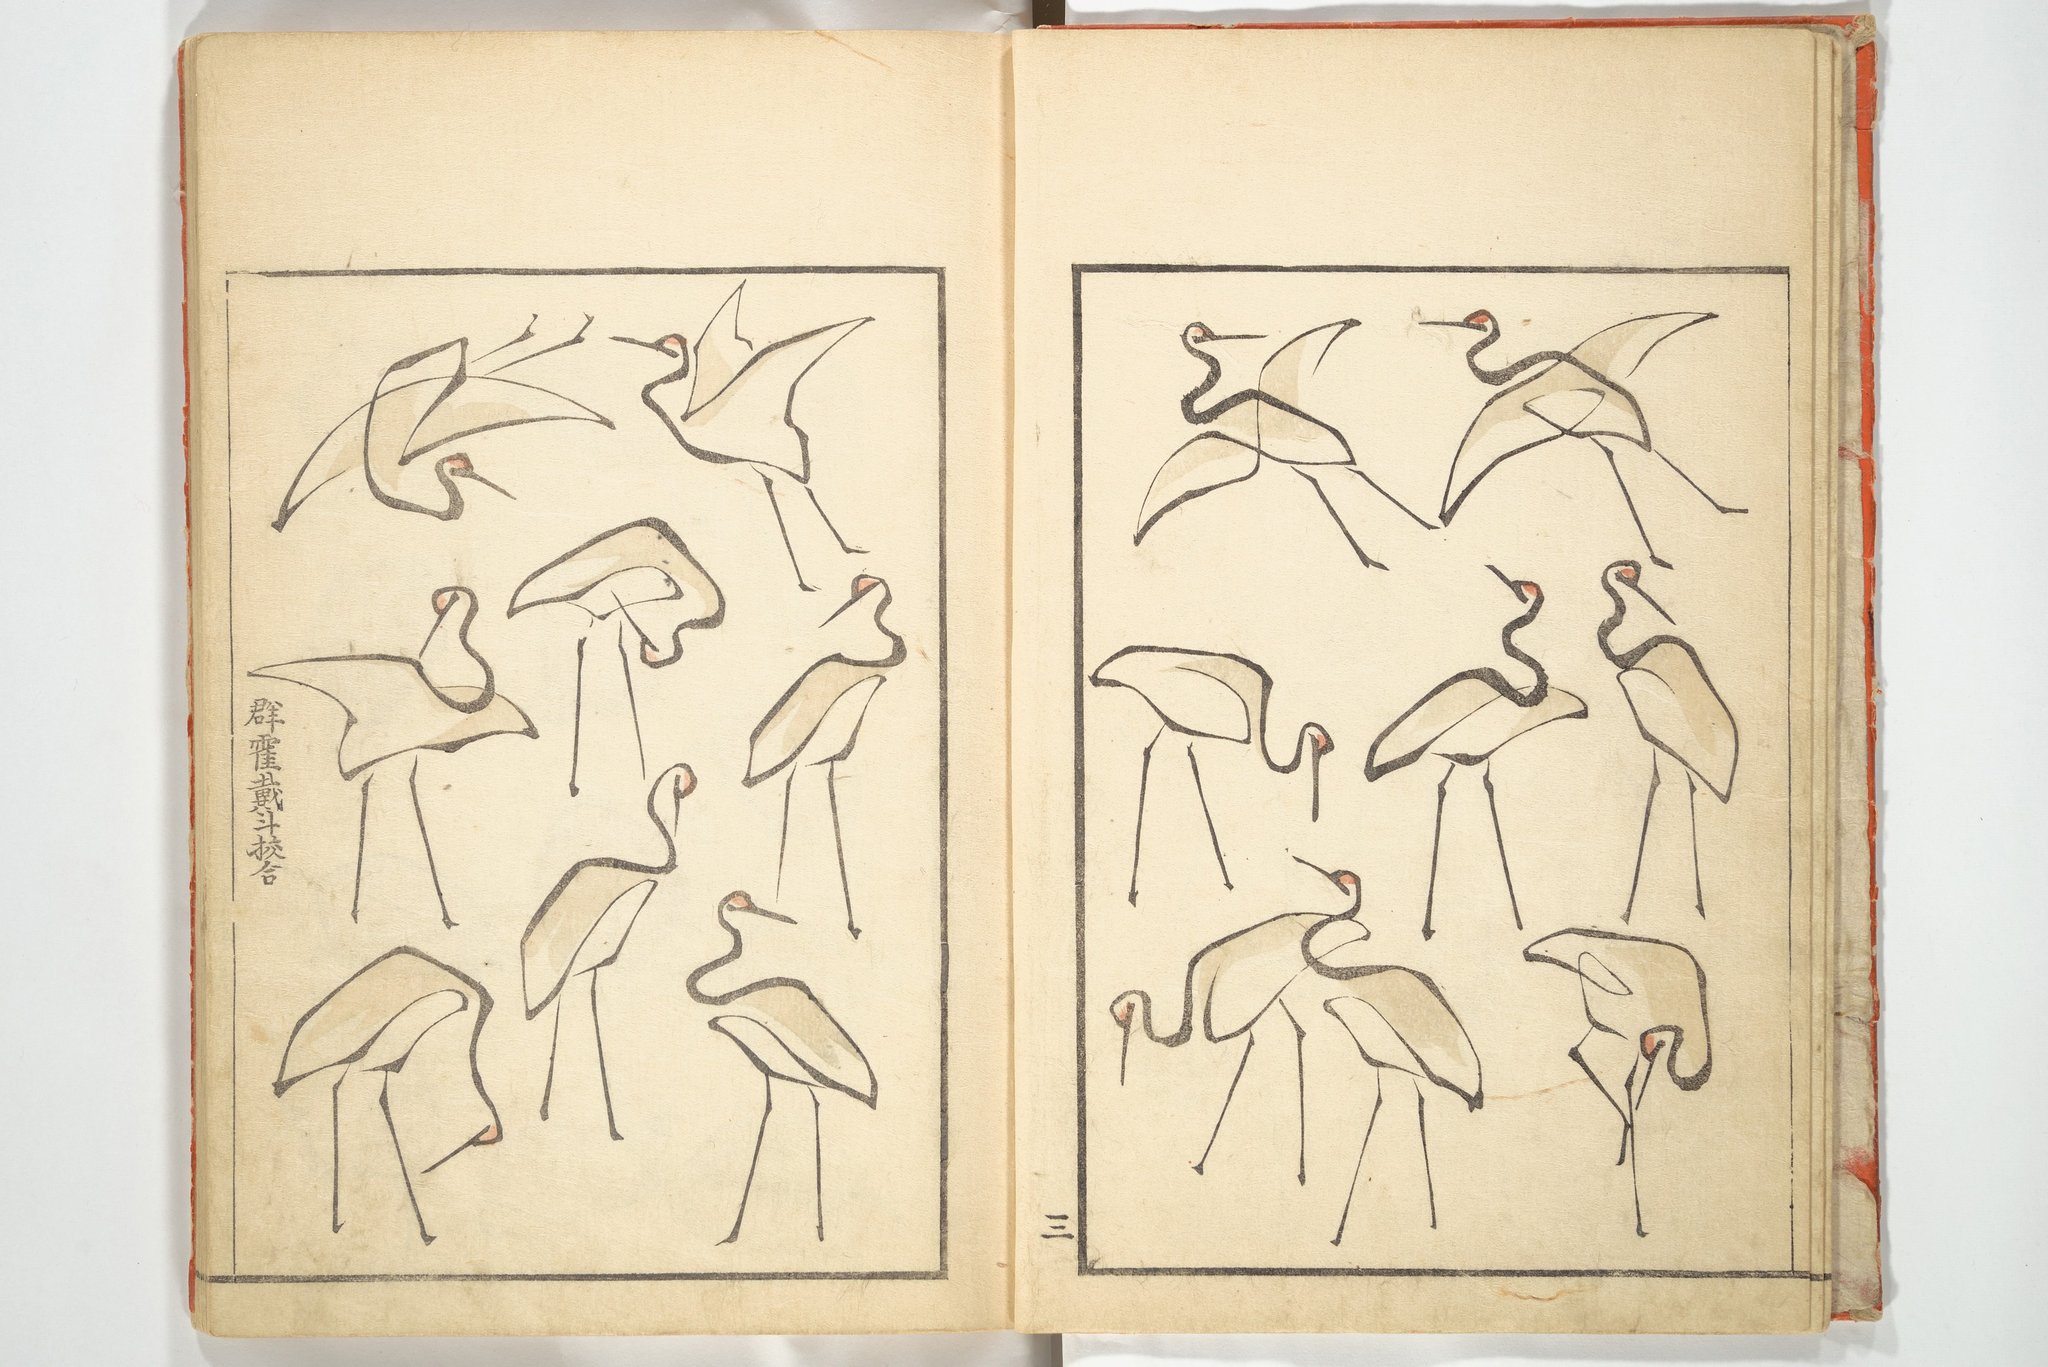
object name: illustrated book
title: Transmitting the Spirit, Revealing Form of Things: Picture Album of Drawings at One Stroke (Denshin kaishu ippitsu gafu) 伝神開手 一筆画譜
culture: japanese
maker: katsushika hokusai 葛飾北斎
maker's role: artist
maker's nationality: japanese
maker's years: 1760-1849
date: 1823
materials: ink, paper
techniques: woodblock print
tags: birds